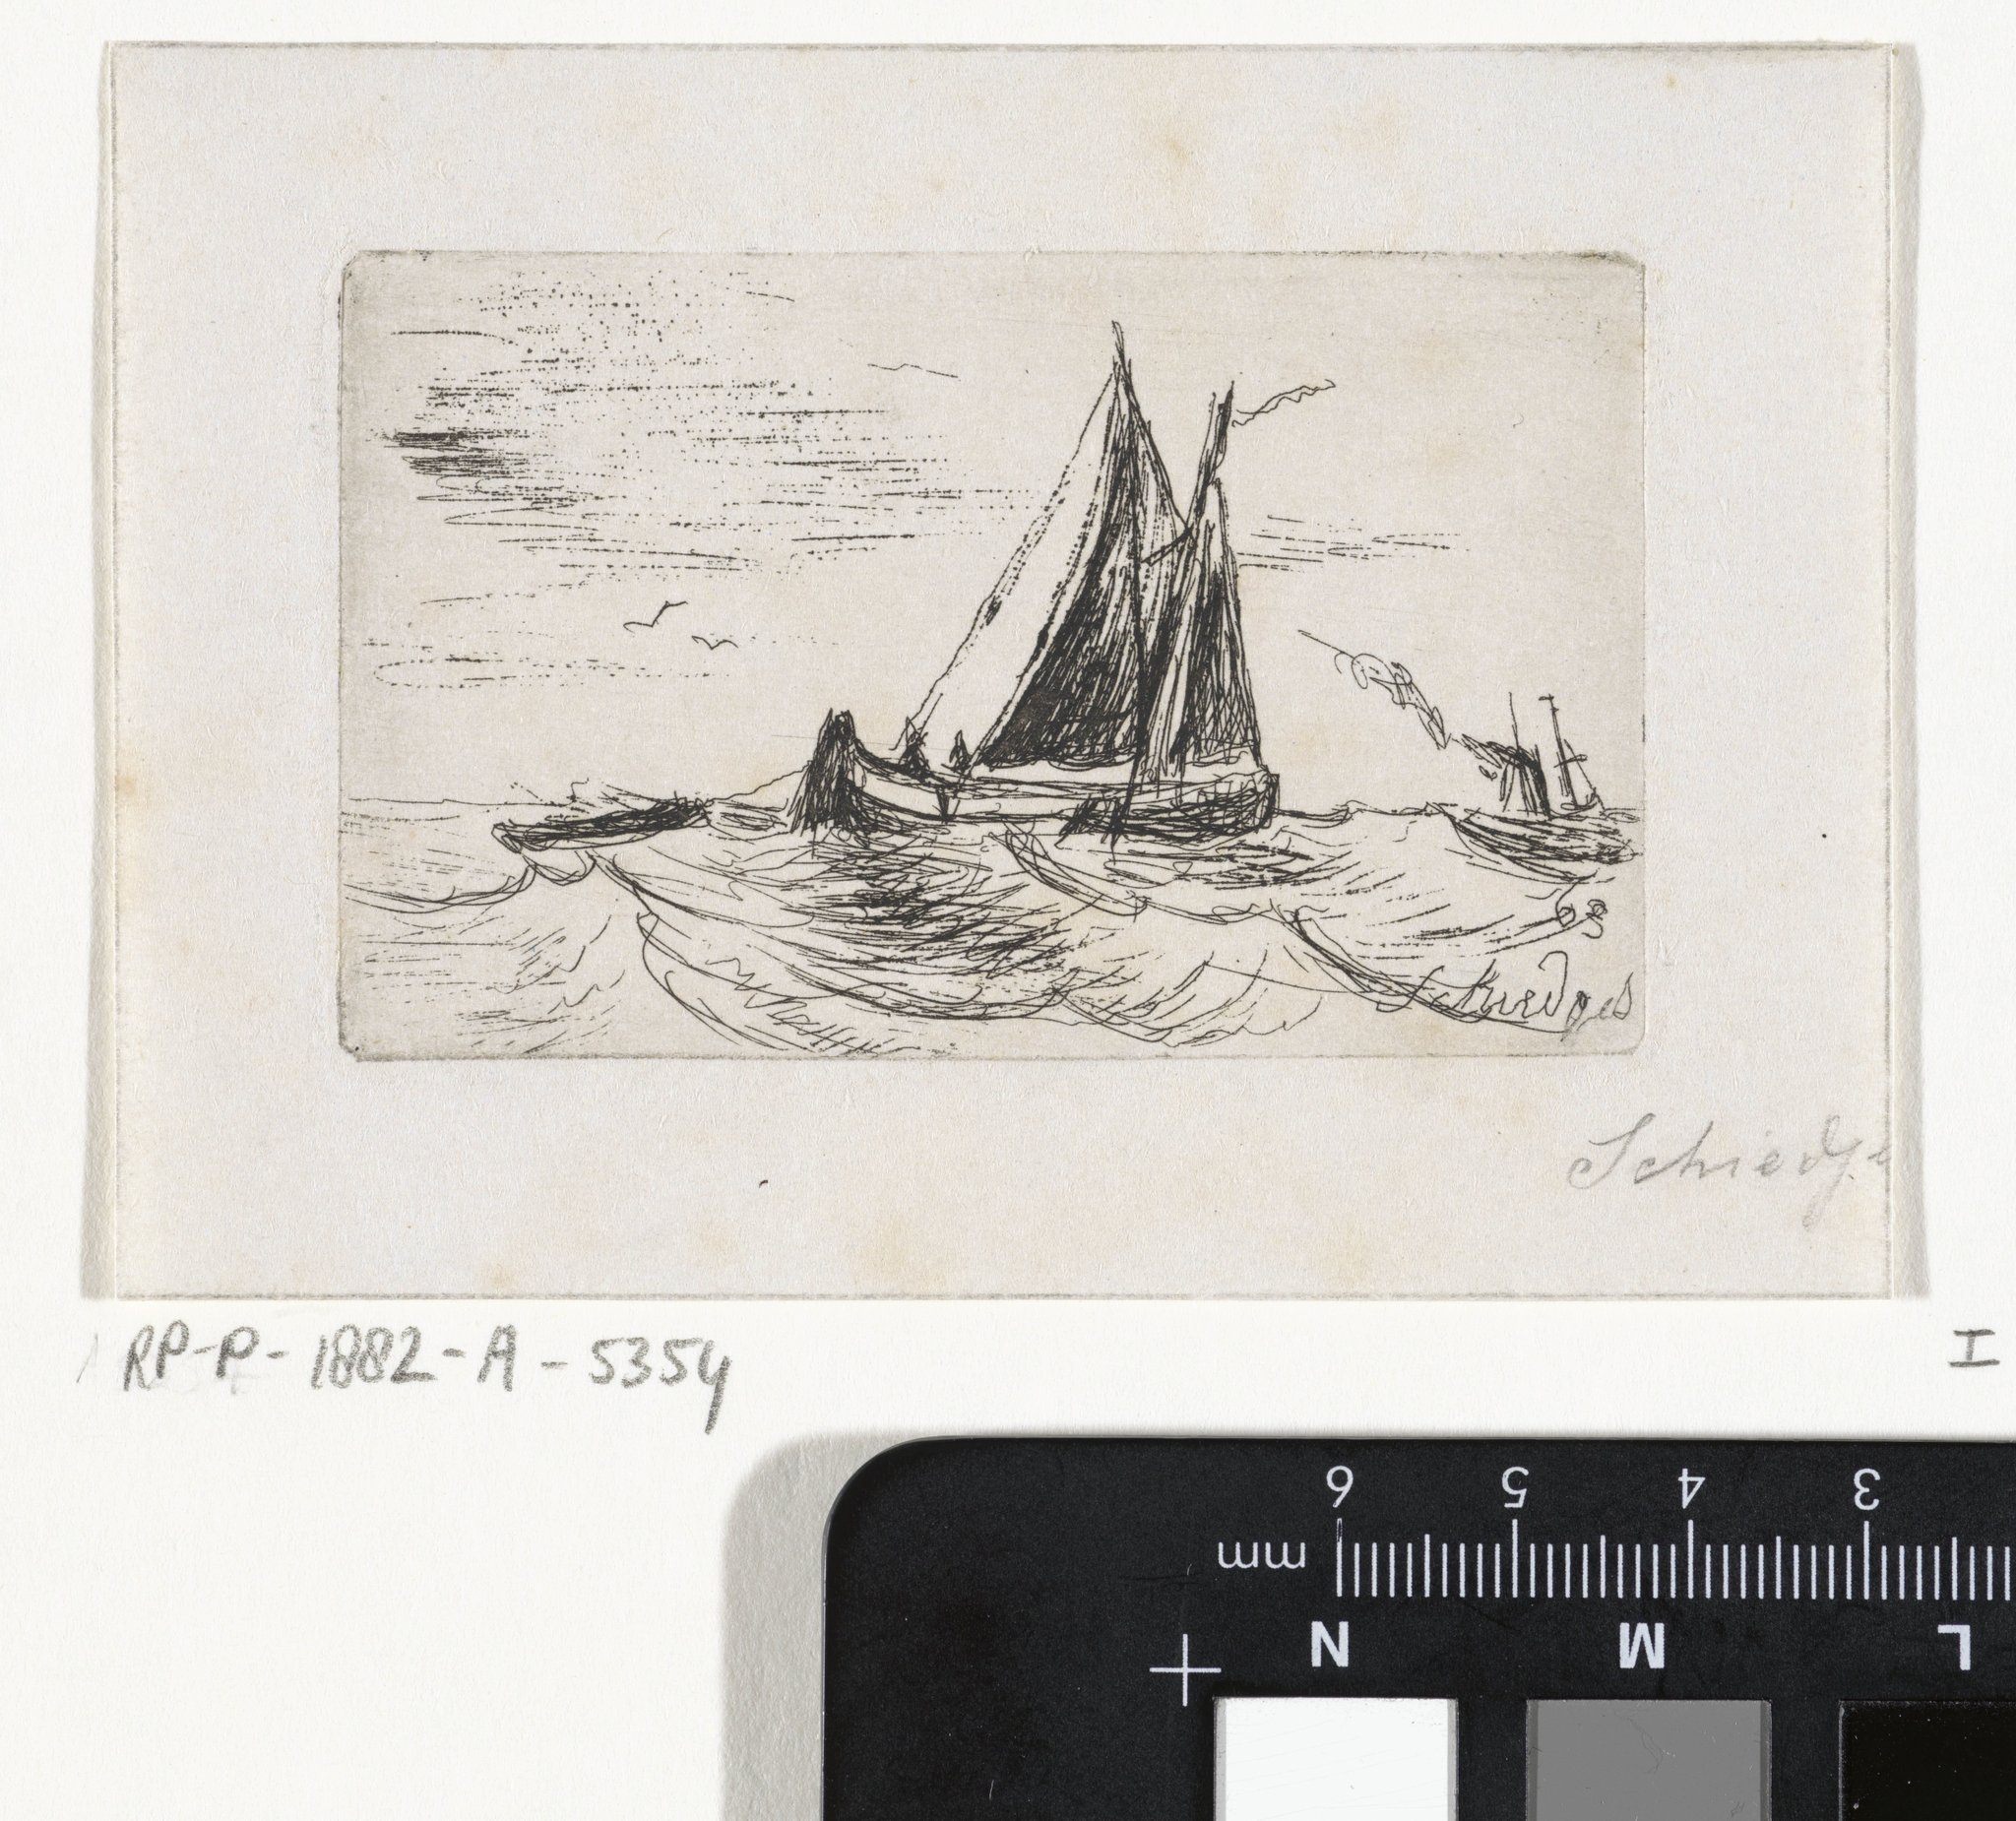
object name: print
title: Zeilschip op zee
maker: petrus paulus schiedges (i)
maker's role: draughtsman, print maker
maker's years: 1813-1876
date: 1863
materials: paper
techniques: etching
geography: the hague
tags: sailing-ship, sailing-boat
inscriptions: collector's mark: Lugt 2228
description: Een zeilschip sleept een sloep en vaart naar rechts. Rechts op de achtergrond een stoomboot.